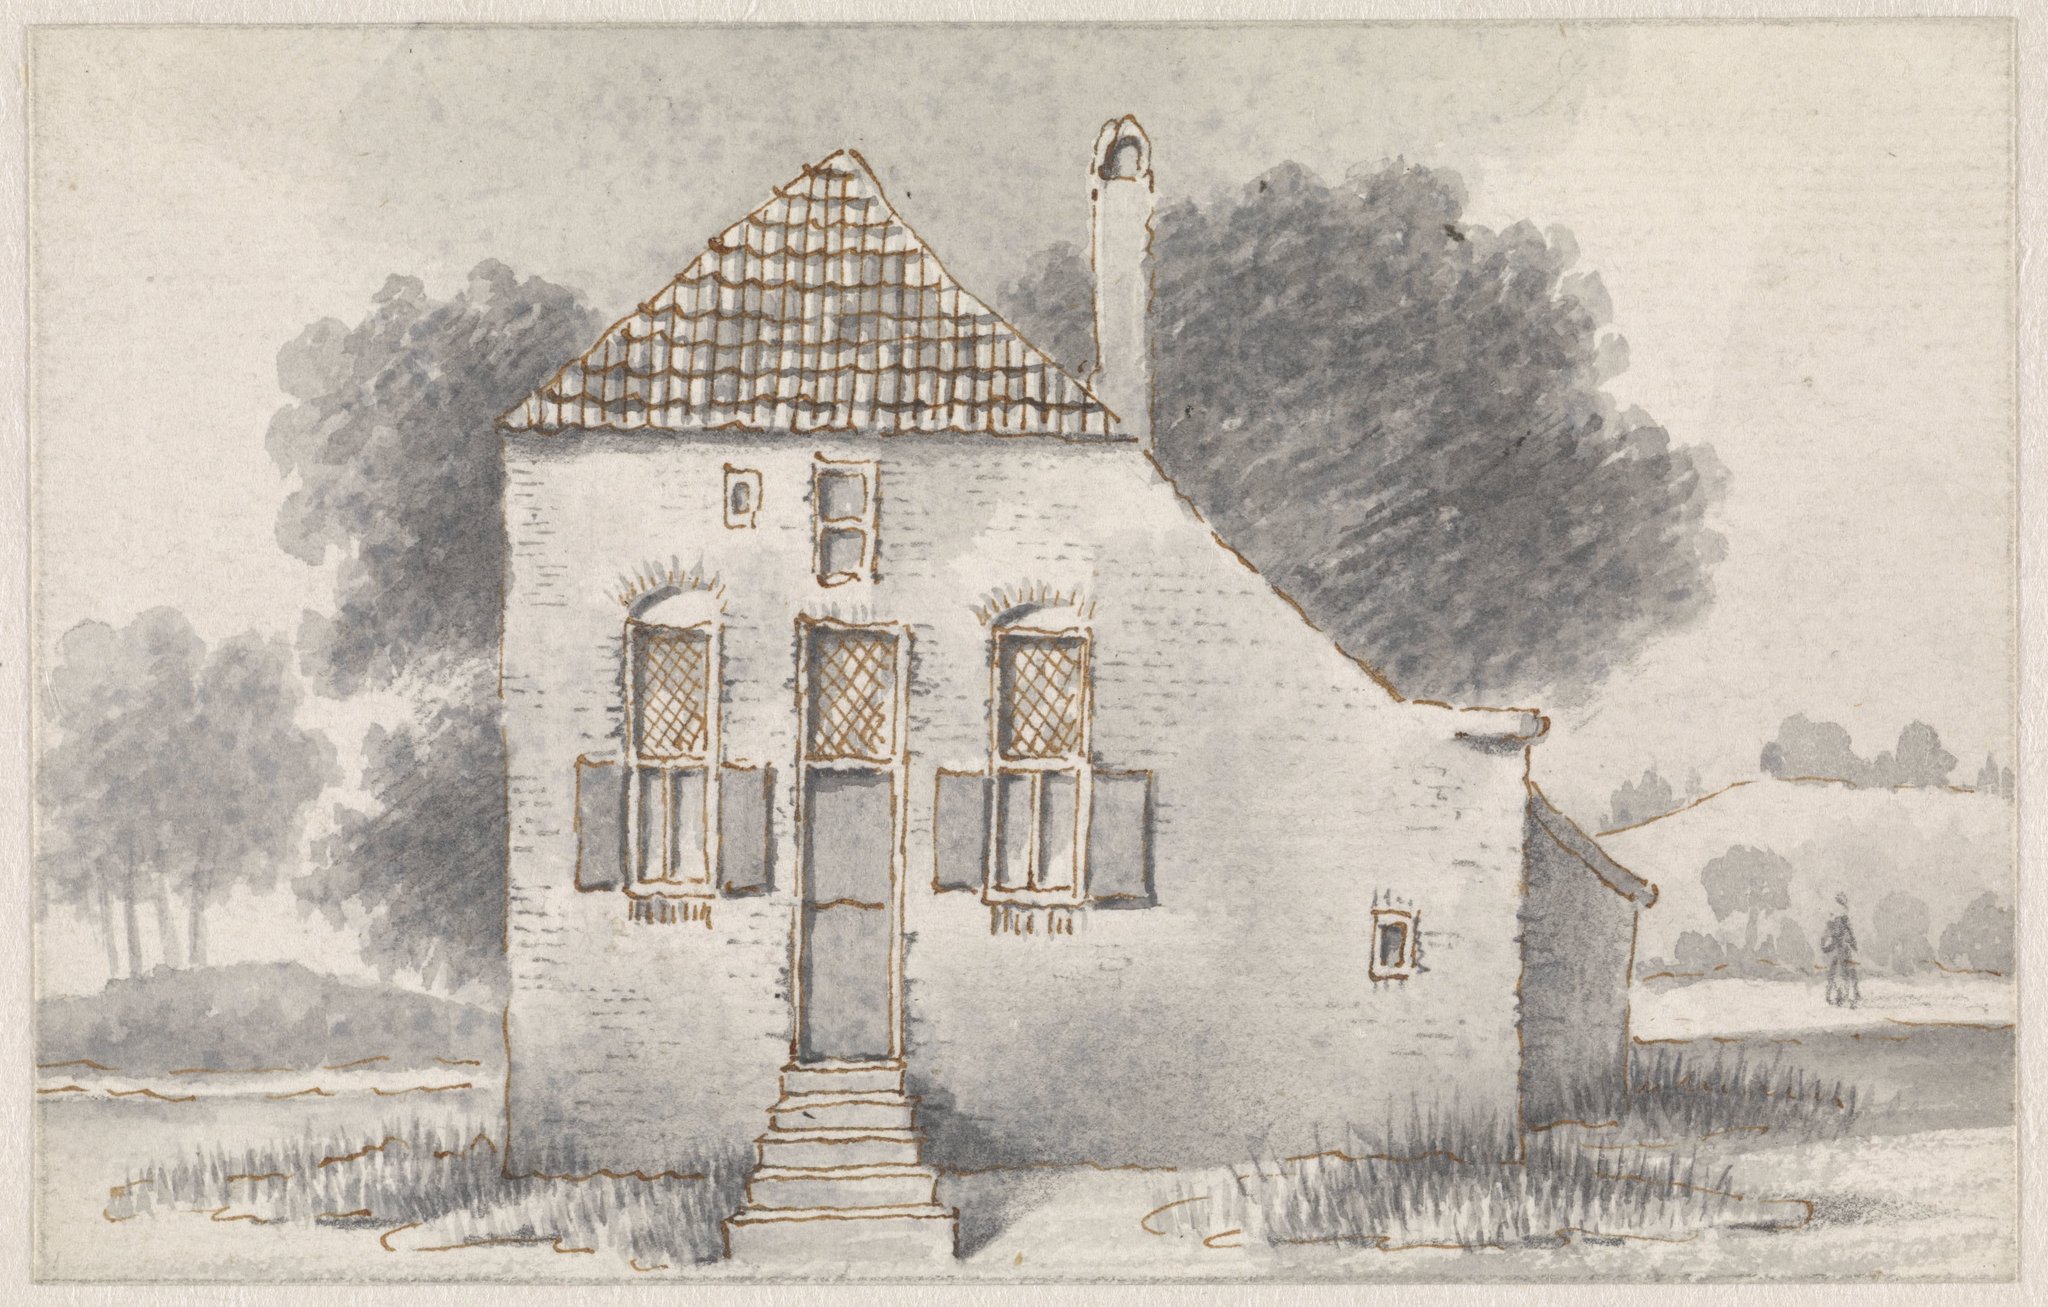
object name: drawing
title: Huis te Zoelmond, in de Betuwe, frontaal gezien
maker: evert doublet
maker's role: draughtsman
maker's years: 1802-1859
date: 1852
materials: ink, paper, pencil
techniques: brush, pen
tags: rural housing, e.g. country-house, villa, cottage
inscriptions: date